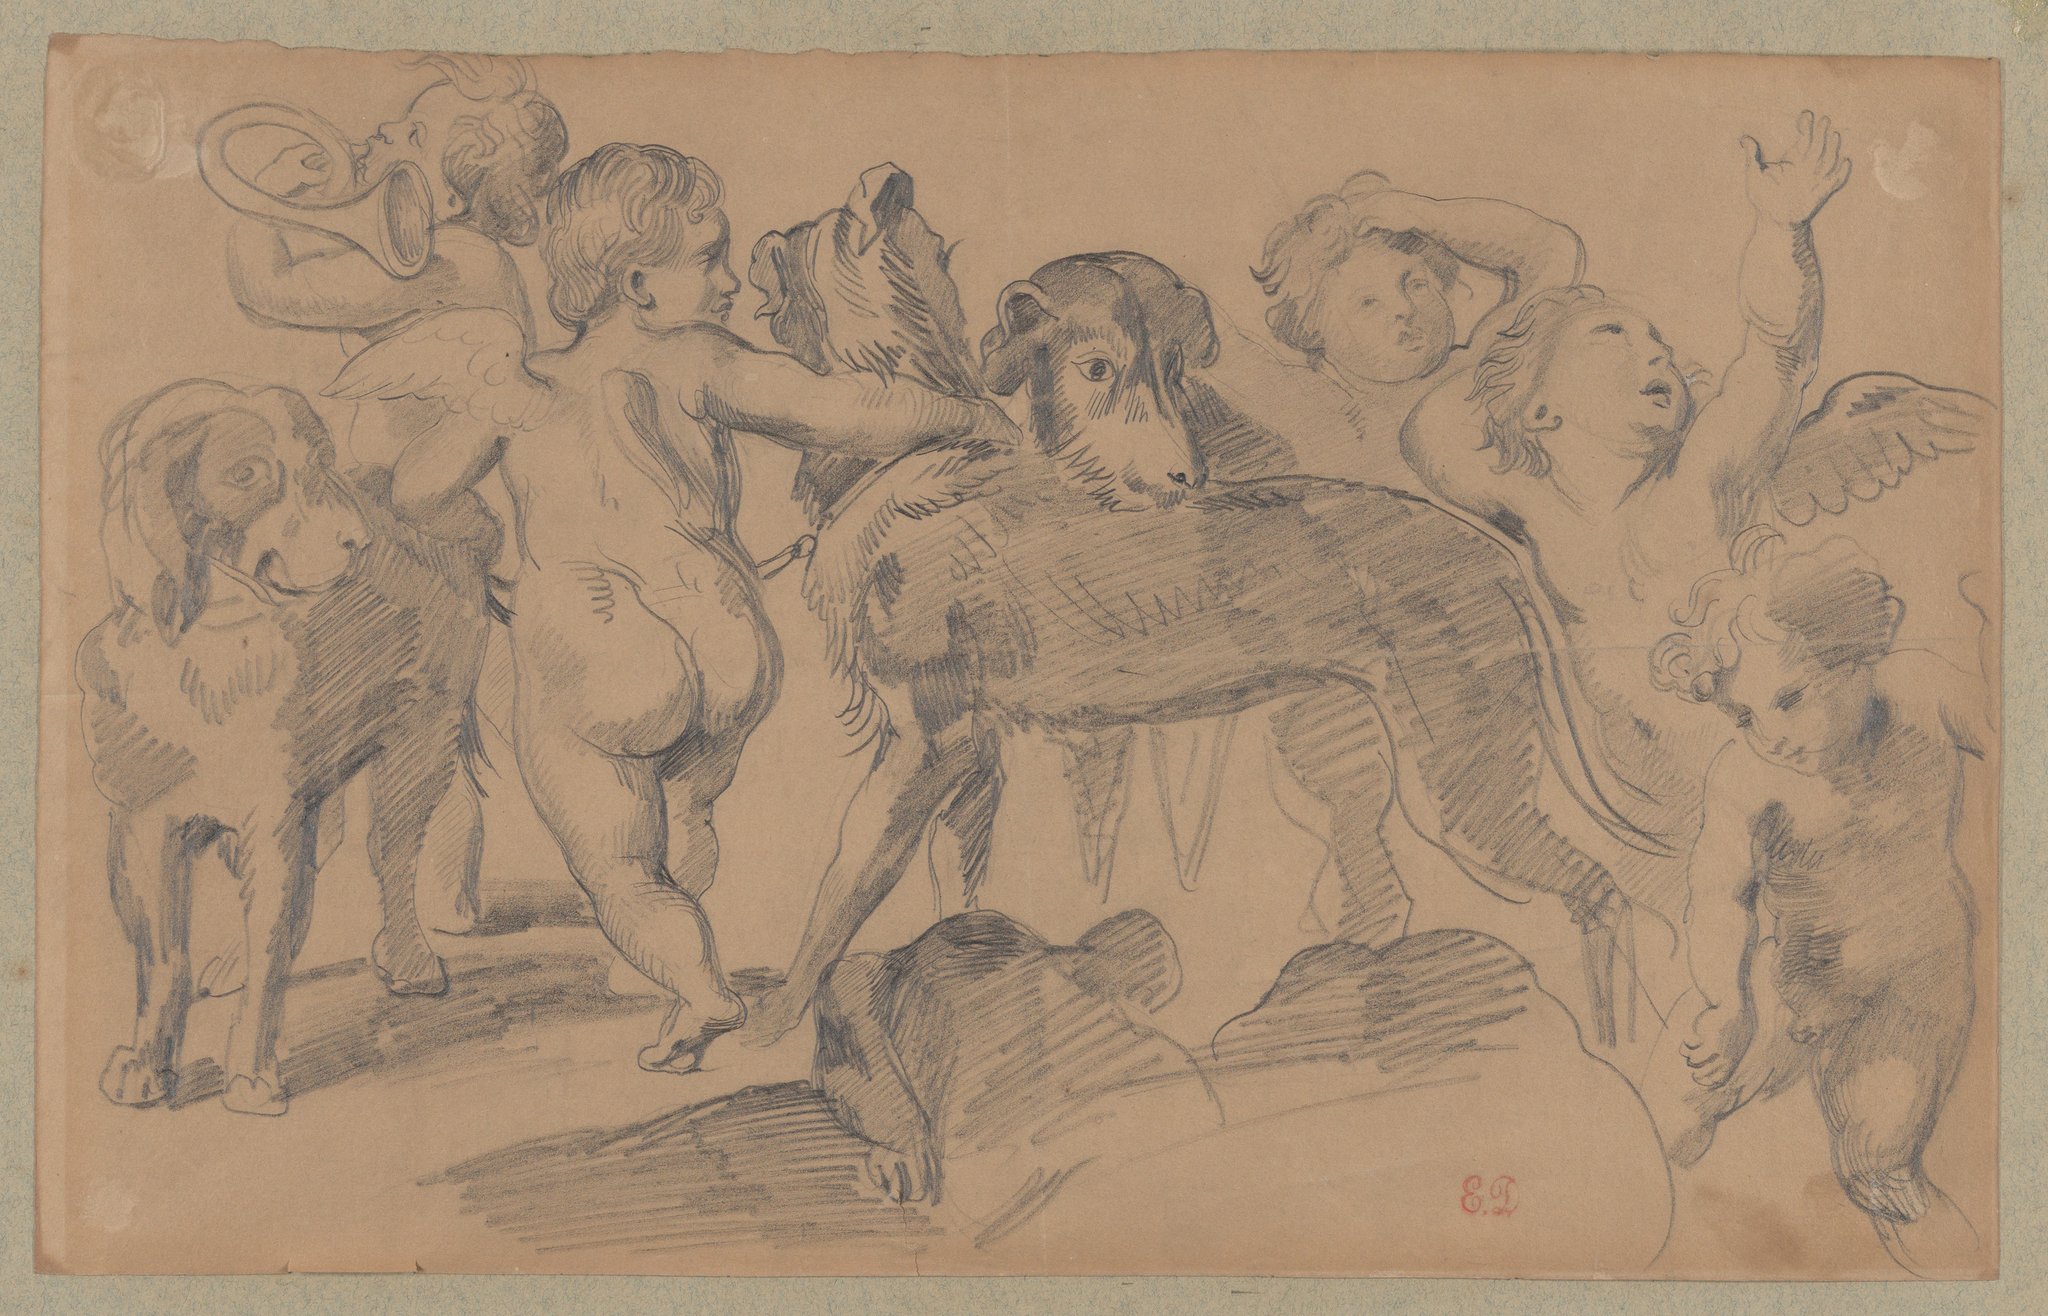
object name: drawing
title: Study of Putti with Dogs, after Peter Paul Rubens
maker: eugène delacroix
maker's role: artist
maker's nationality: french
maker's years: 1798-1863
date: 1820-1863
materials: graphite